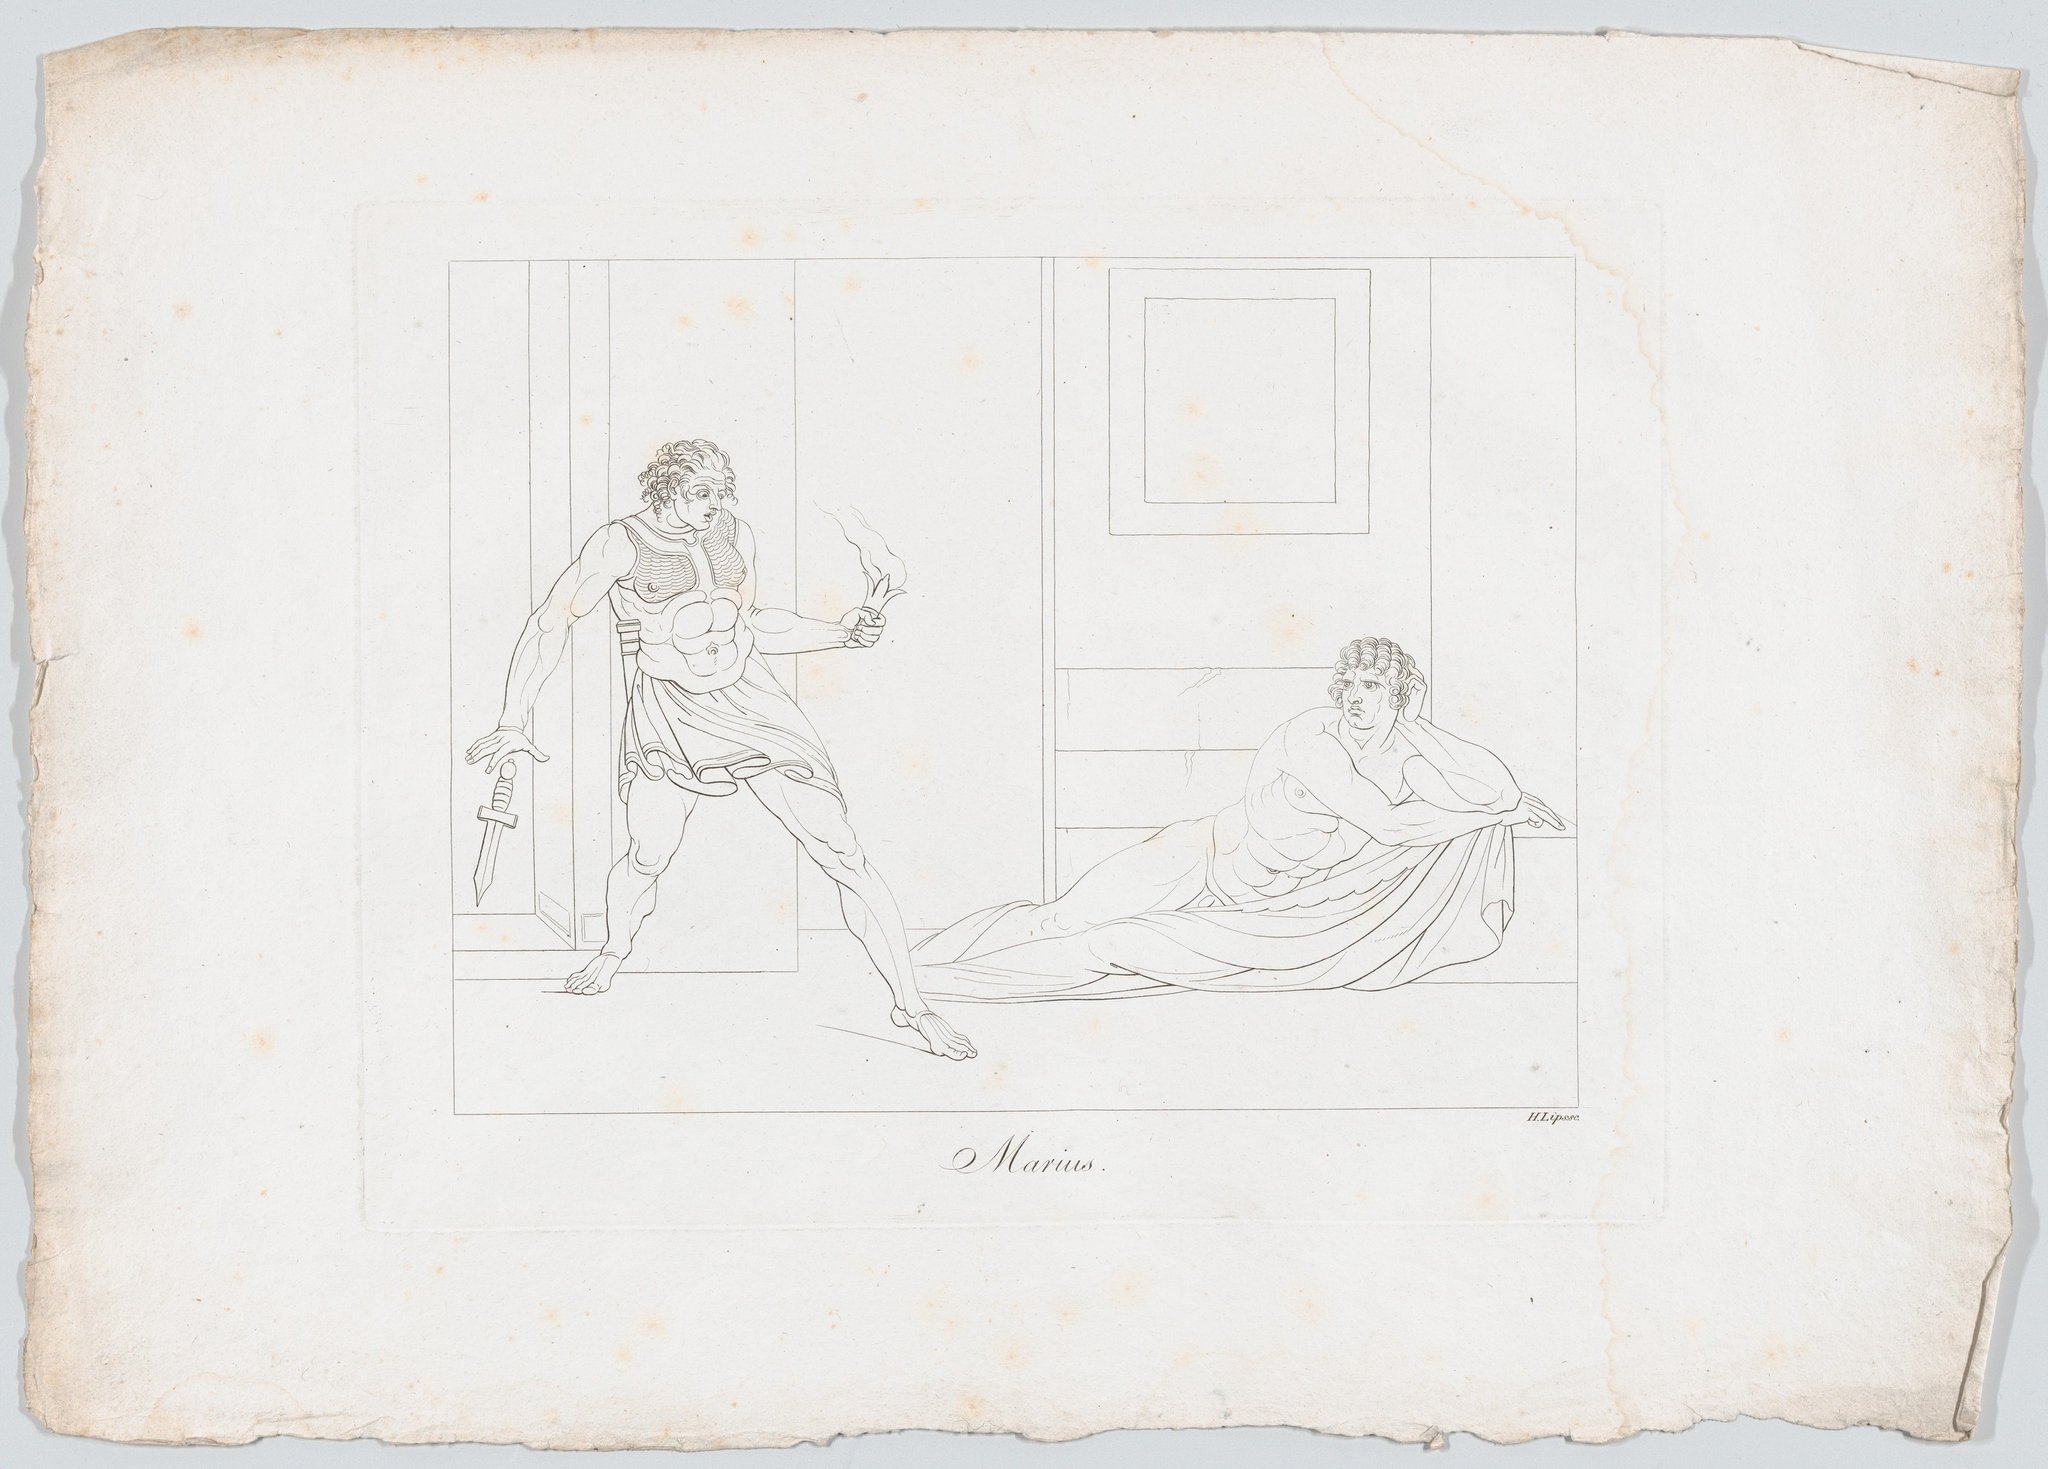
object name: print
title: Caius Marius and the Cimbrian Soldier (Plutarch, "Marius," 39; Lucan, "Pharsalia," XI, 75-86)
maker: johann heinrich lips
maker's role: engraver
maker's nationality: swiss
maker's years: 1758-1817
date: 1806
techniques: engraving, etching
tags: soldiers,male nudes